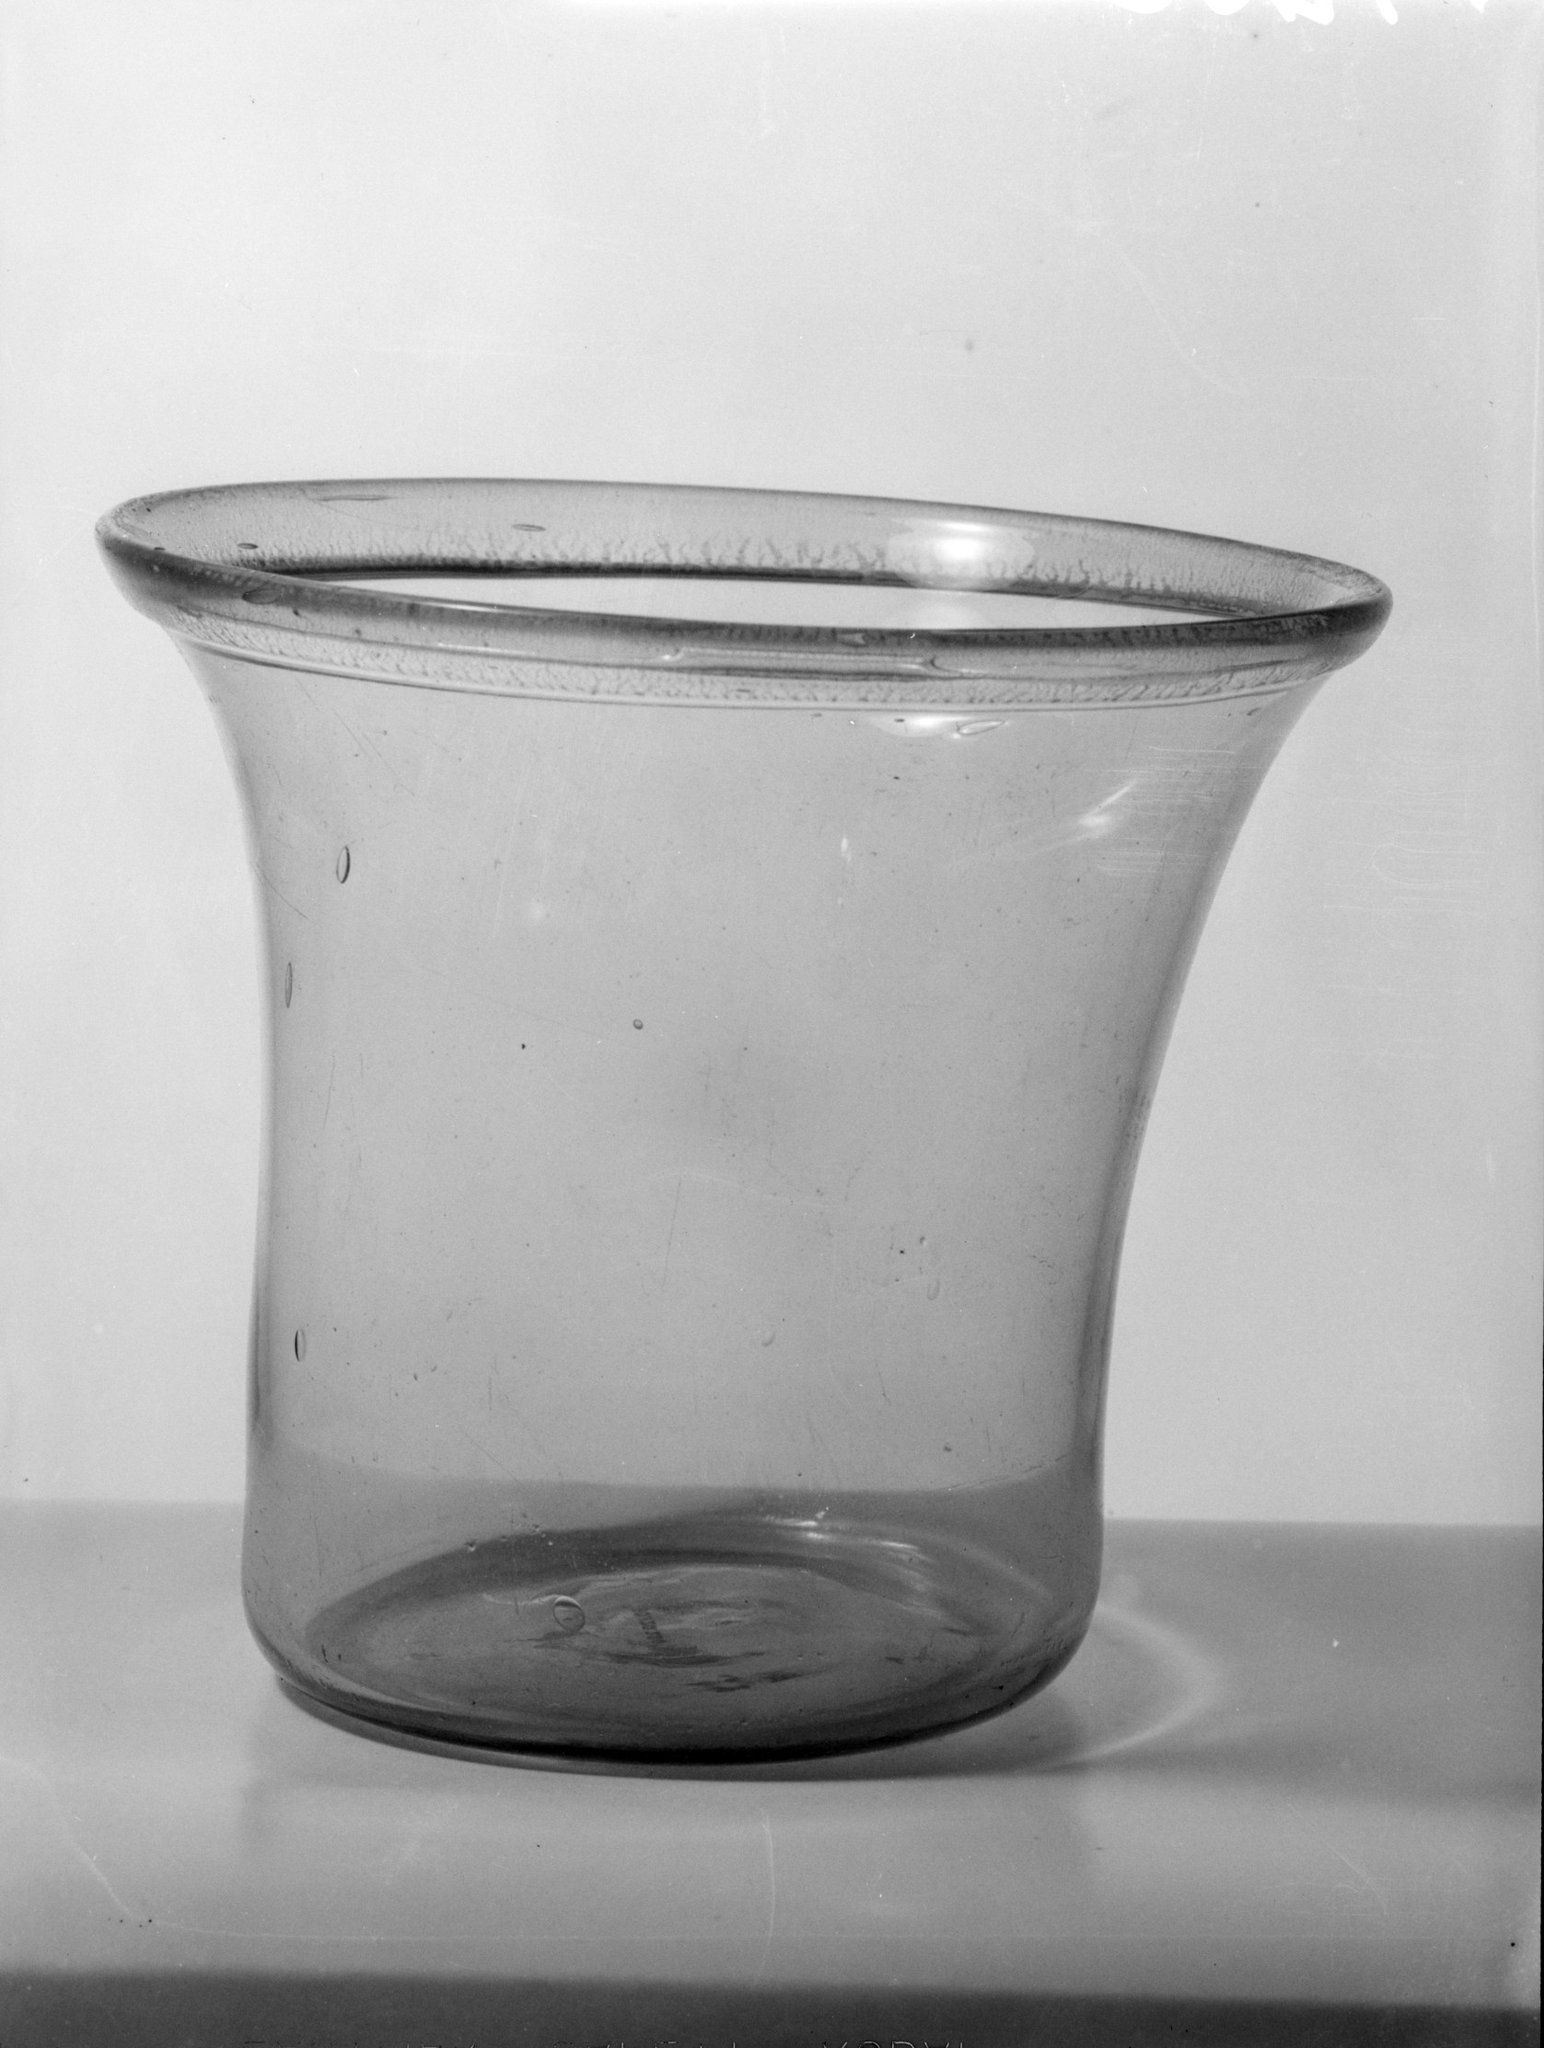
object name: milk bowl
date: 1800-1830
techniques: glassblowing